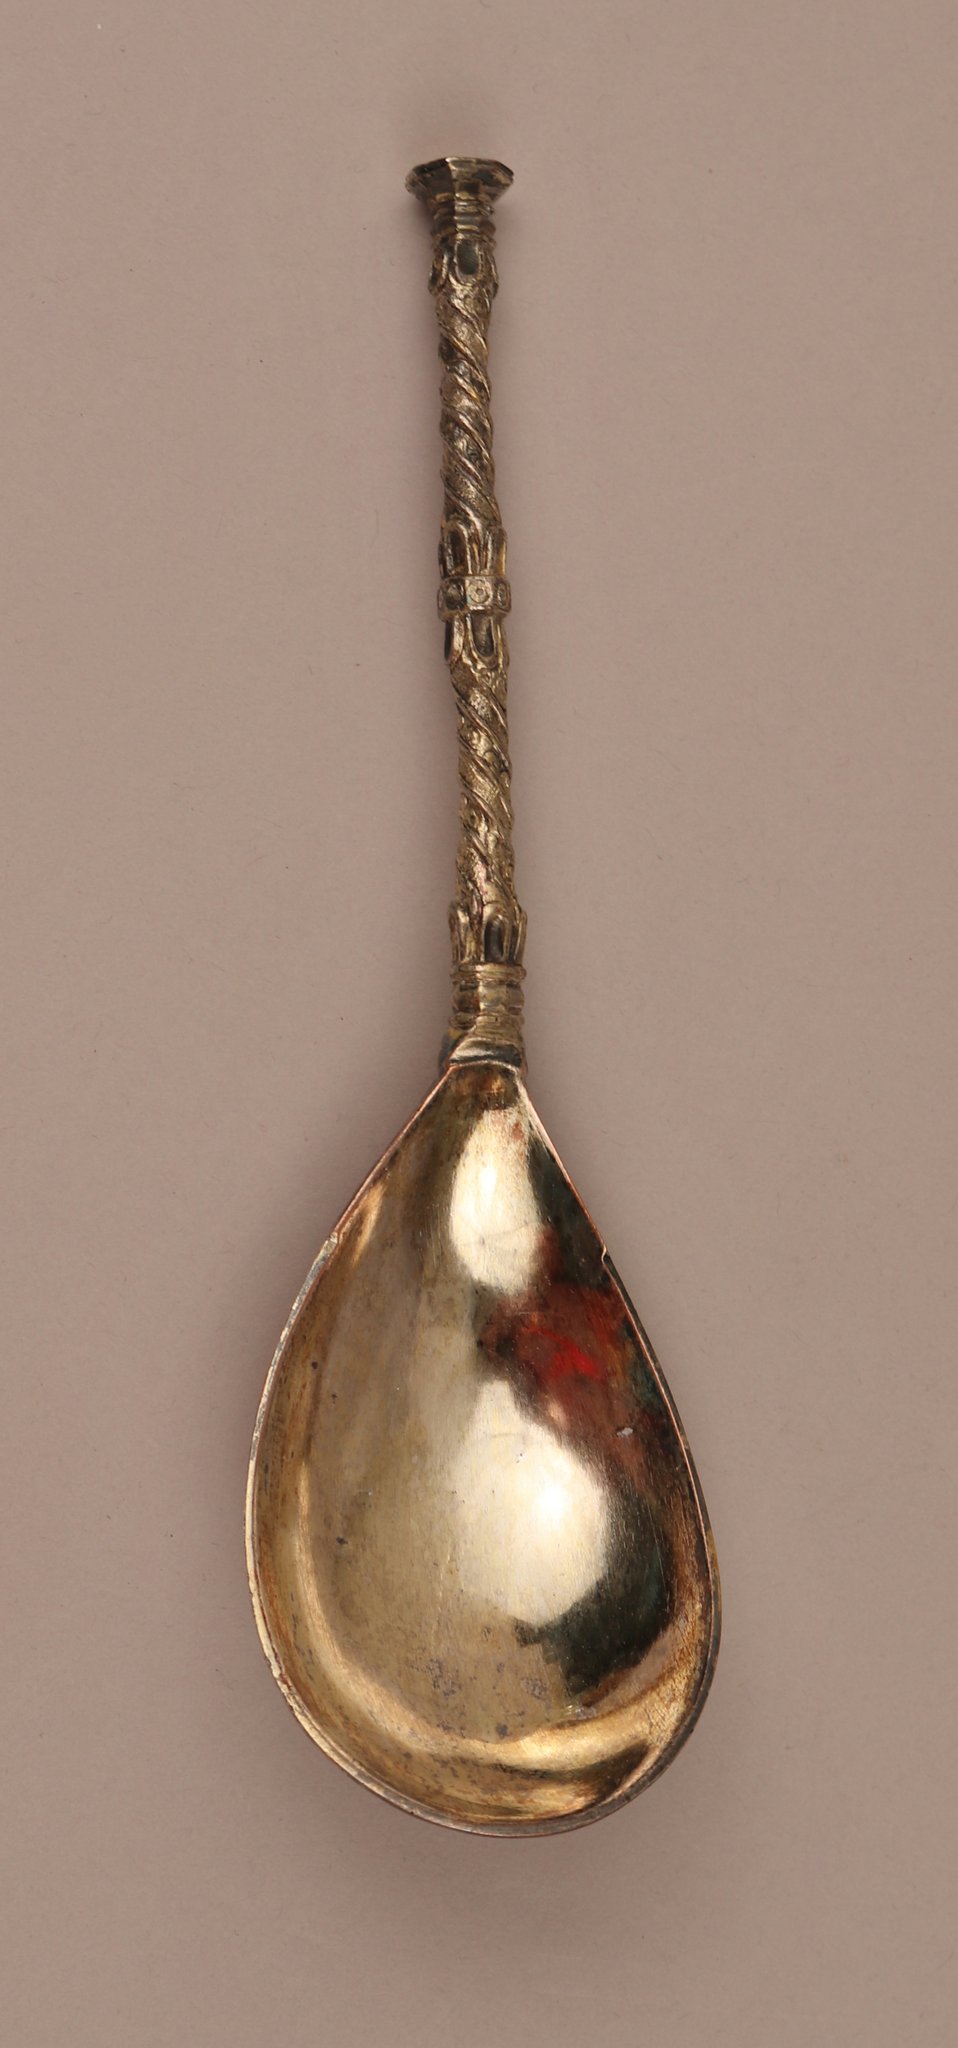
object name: spoon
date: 1801-1900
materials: metal, silver